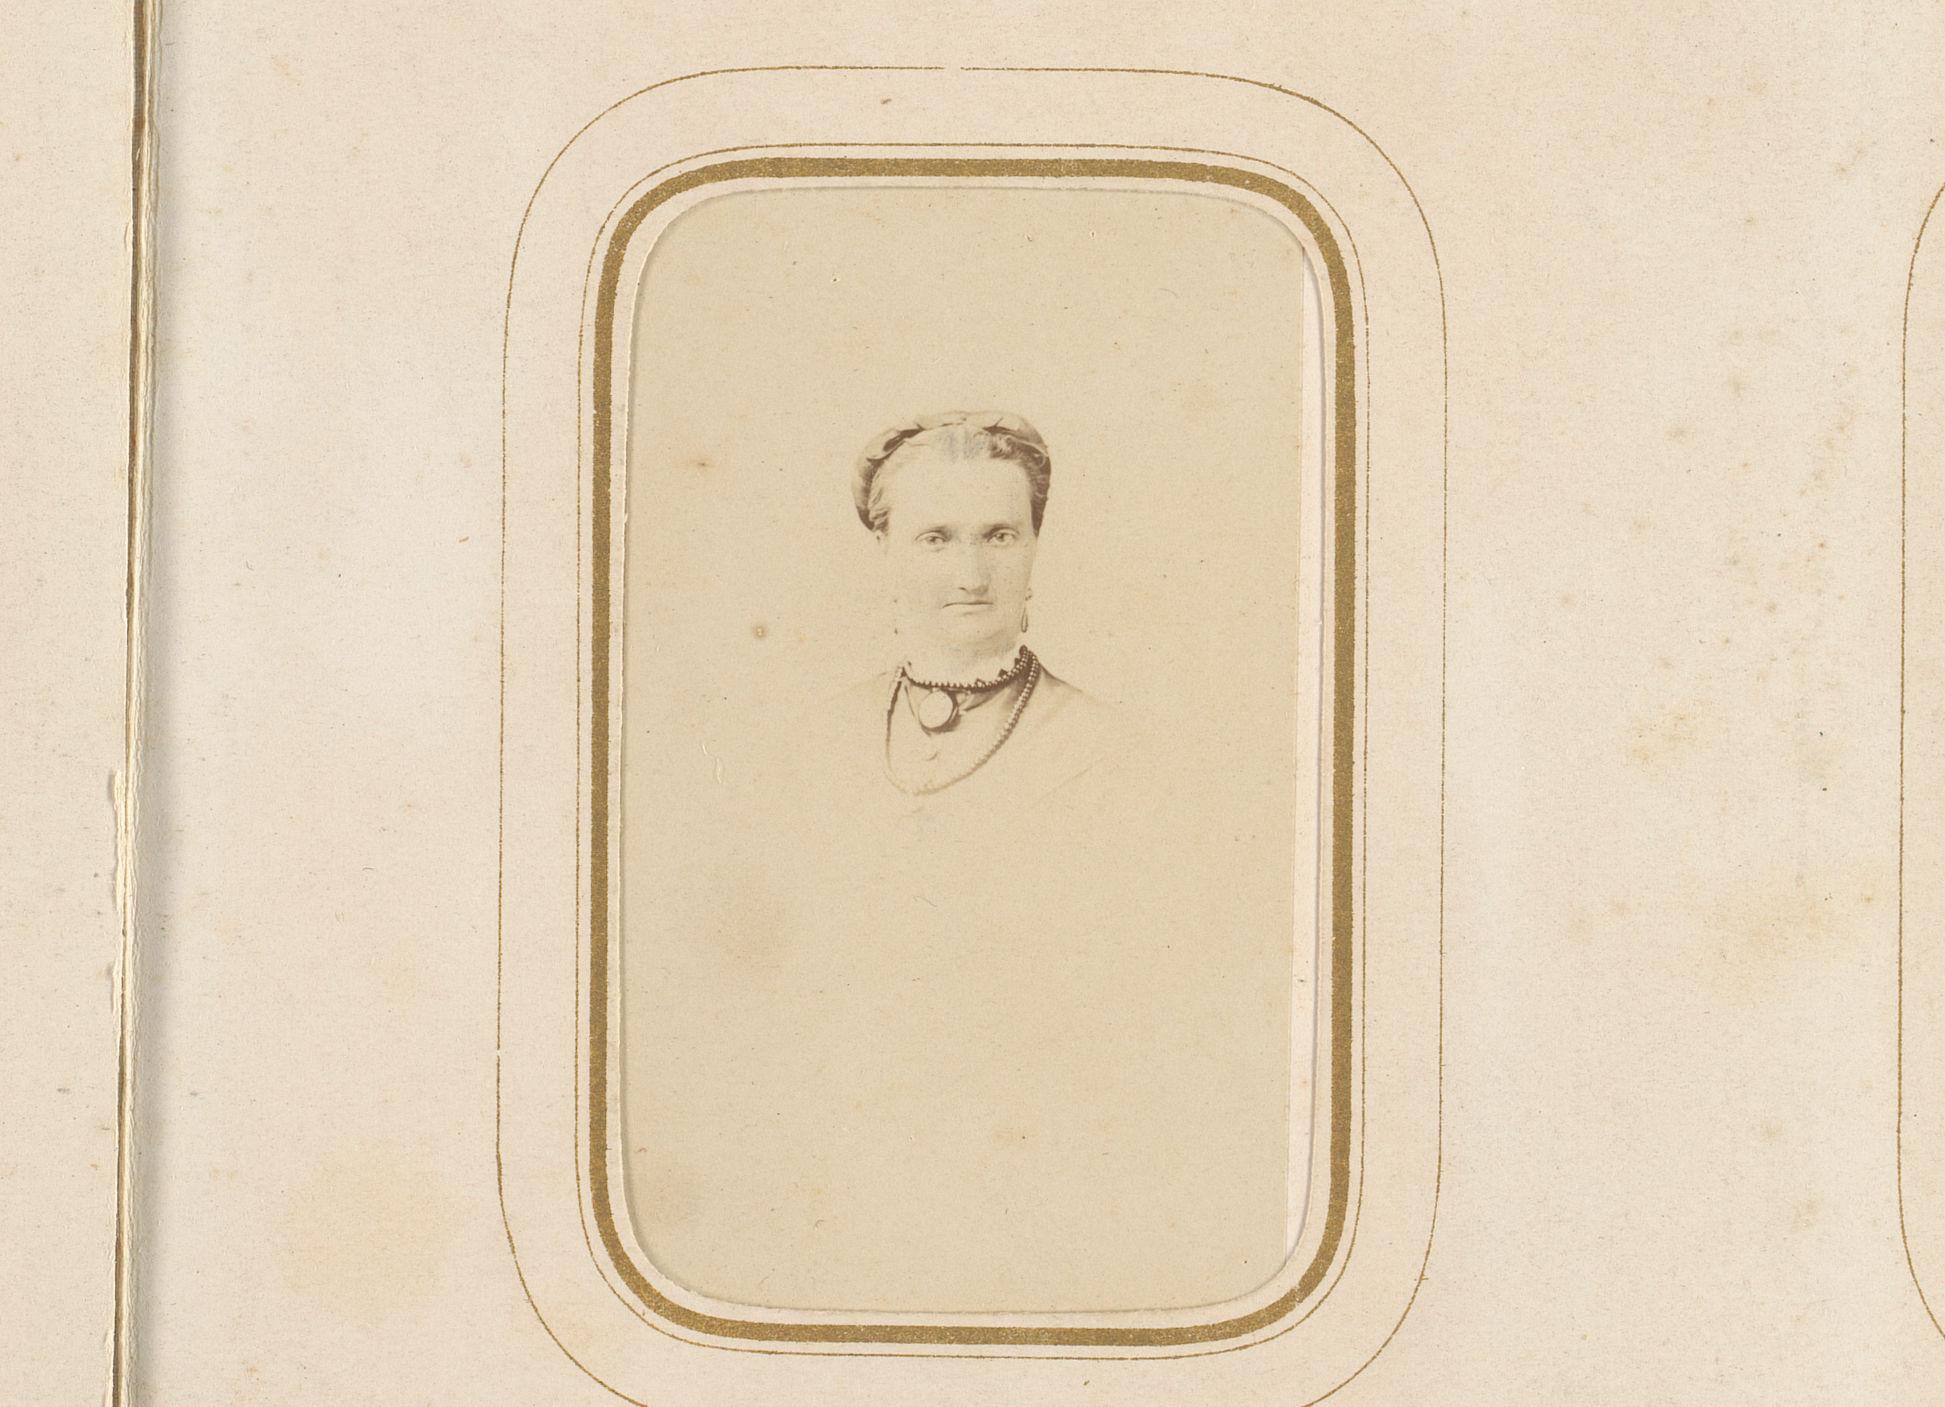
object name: album leaf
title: Portret van een vrouw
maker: numa blanc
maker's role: publisher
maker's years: 1816-1897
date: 1860-1890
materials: cardboard, photographic support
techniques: albumen print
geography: paris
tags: historical persons - bb - woman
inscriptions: inscription: ‘Paris 1867/ Numa Blanc/ Langerock sr/ Peintre-Photographe/ De S.M. le roi de Prusse/ 29, Bould des Italiens, 29/ Paris’